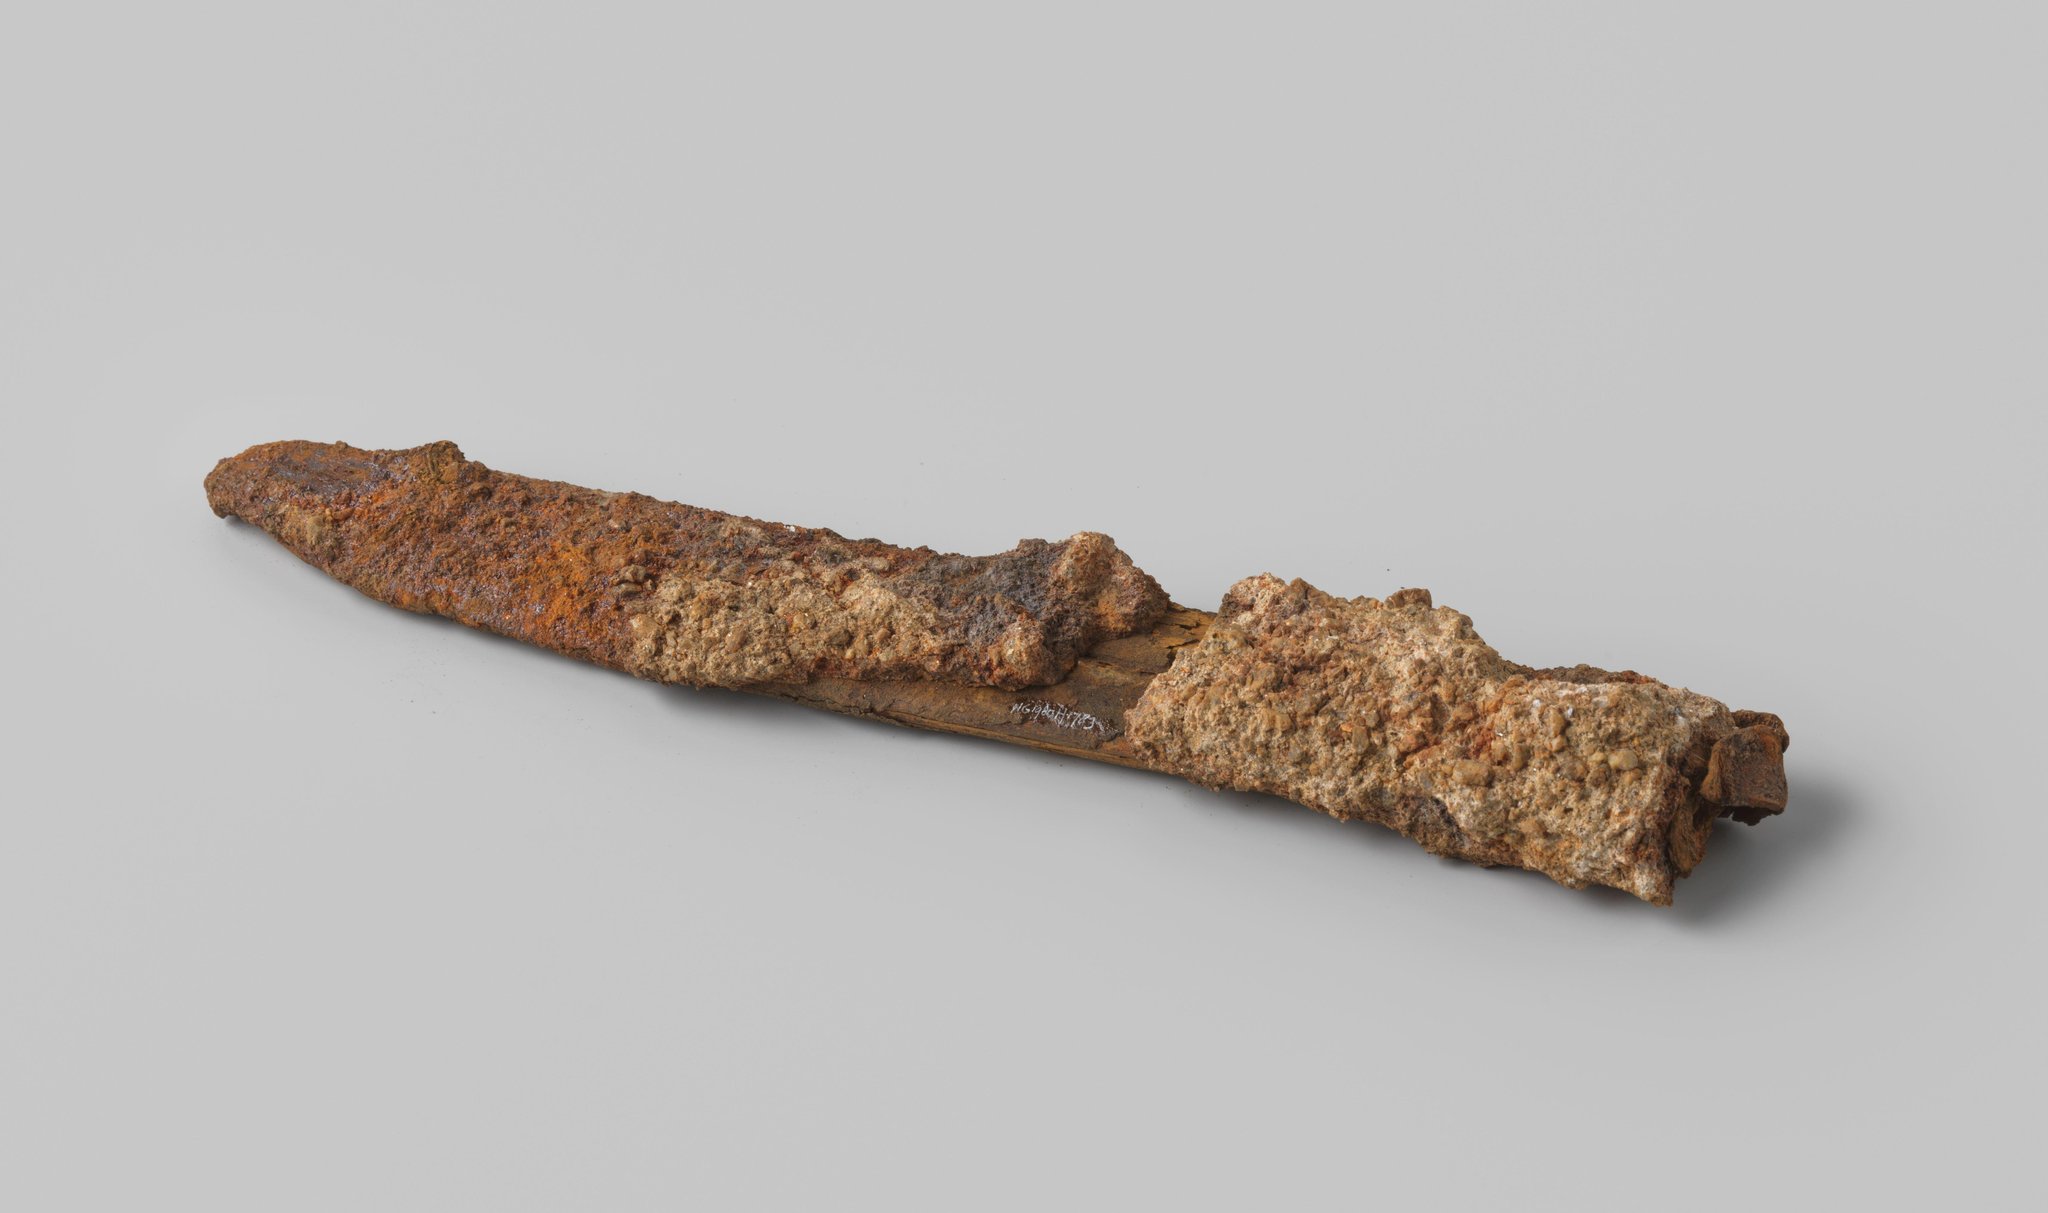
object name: knife with sheath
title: Schede met concretie uit het wrak van de Oost-Indiëvaarder Hollandia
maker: Anonymous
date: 1700-1743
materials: stone, leather, wood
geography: netherlands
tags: verenigde oostindische compagnie, hollandia (schip), annet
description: Scabbard; fragm, lower end, concreted, end broken off, tapering, with remains of leather cover.